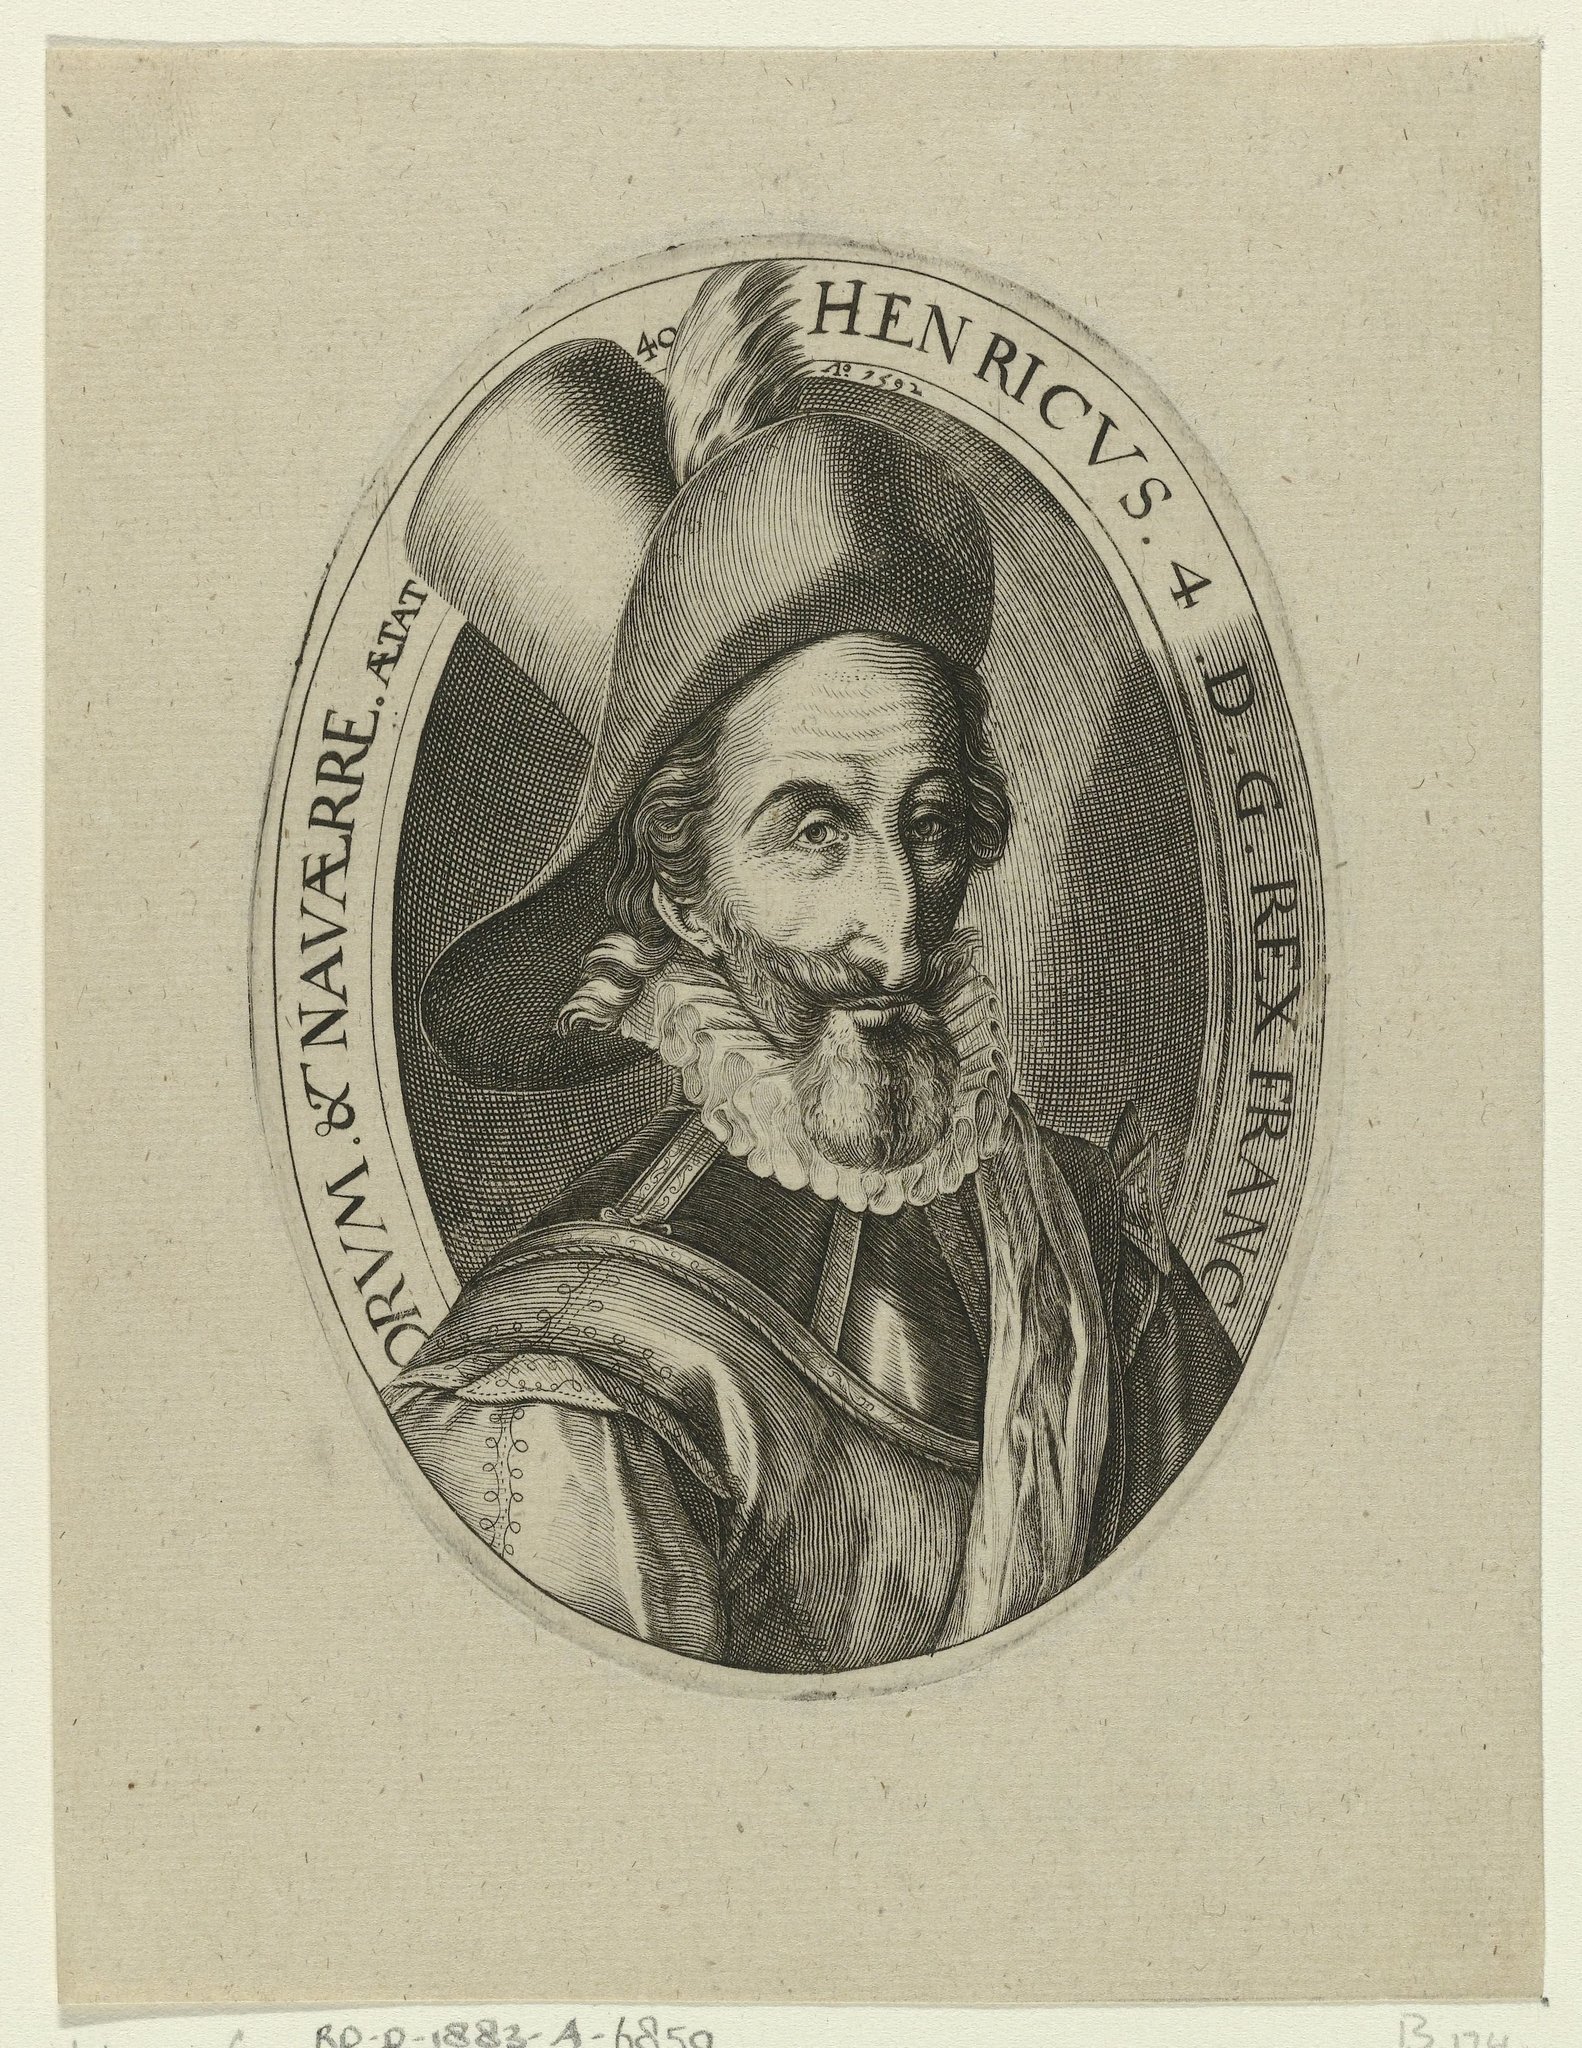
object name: print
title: Portret van koning Hendrik IV van Frankrijk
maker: Anonymous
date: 1592-1667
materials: paper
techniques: engraving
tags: paris, hendrik iv (koning van frankrijk en navarra), head-gear: hat (+ men's clothes)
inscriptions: collector's mark: Lugt 2228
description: Portret van koning Hendrik IV van Frankrijk en Navarra op 40-jarige leeftijd.